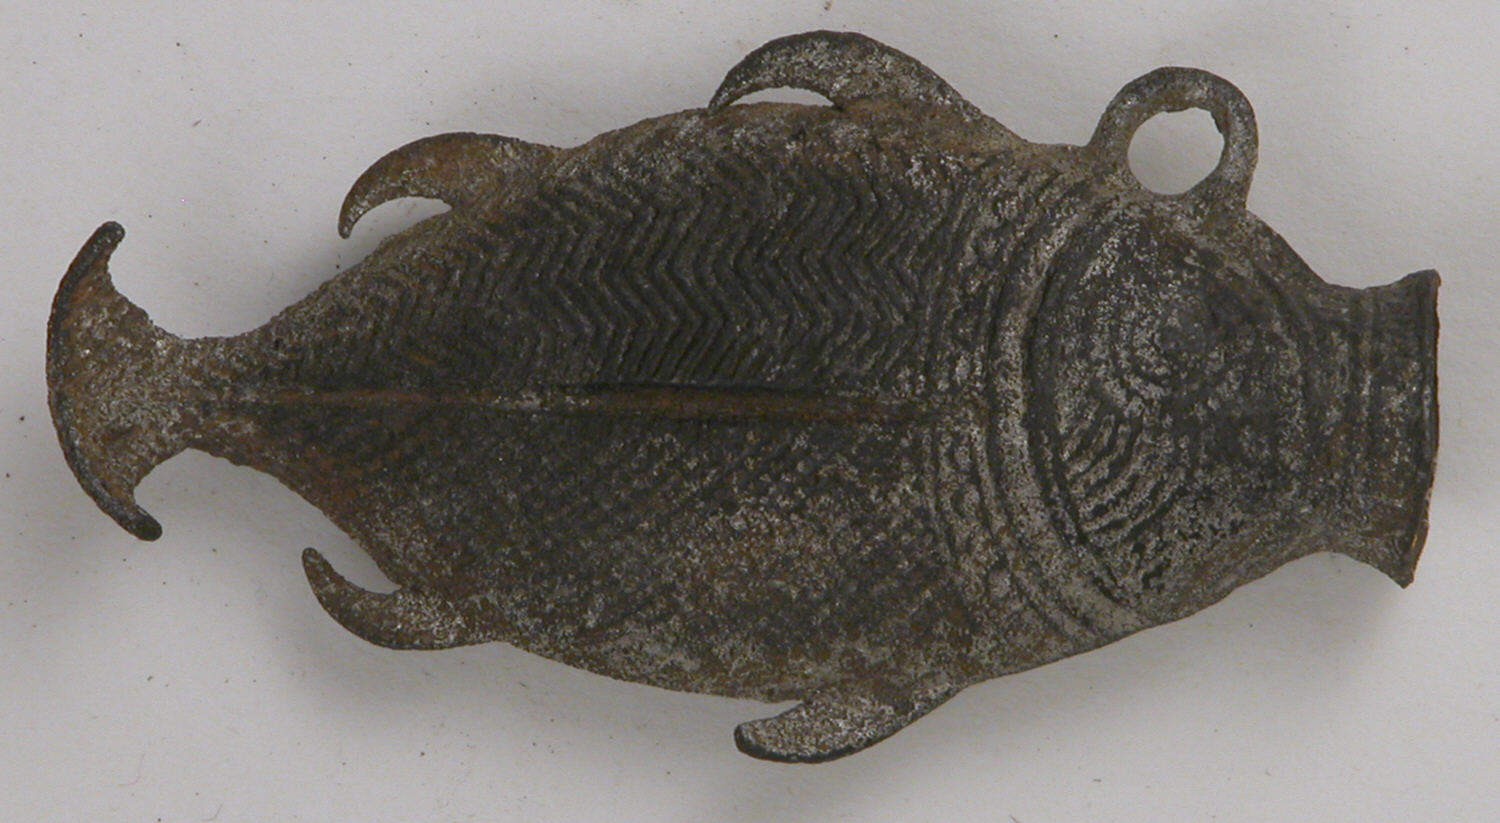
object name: bottle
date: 1301-1400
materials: lead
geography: egypt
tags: fish